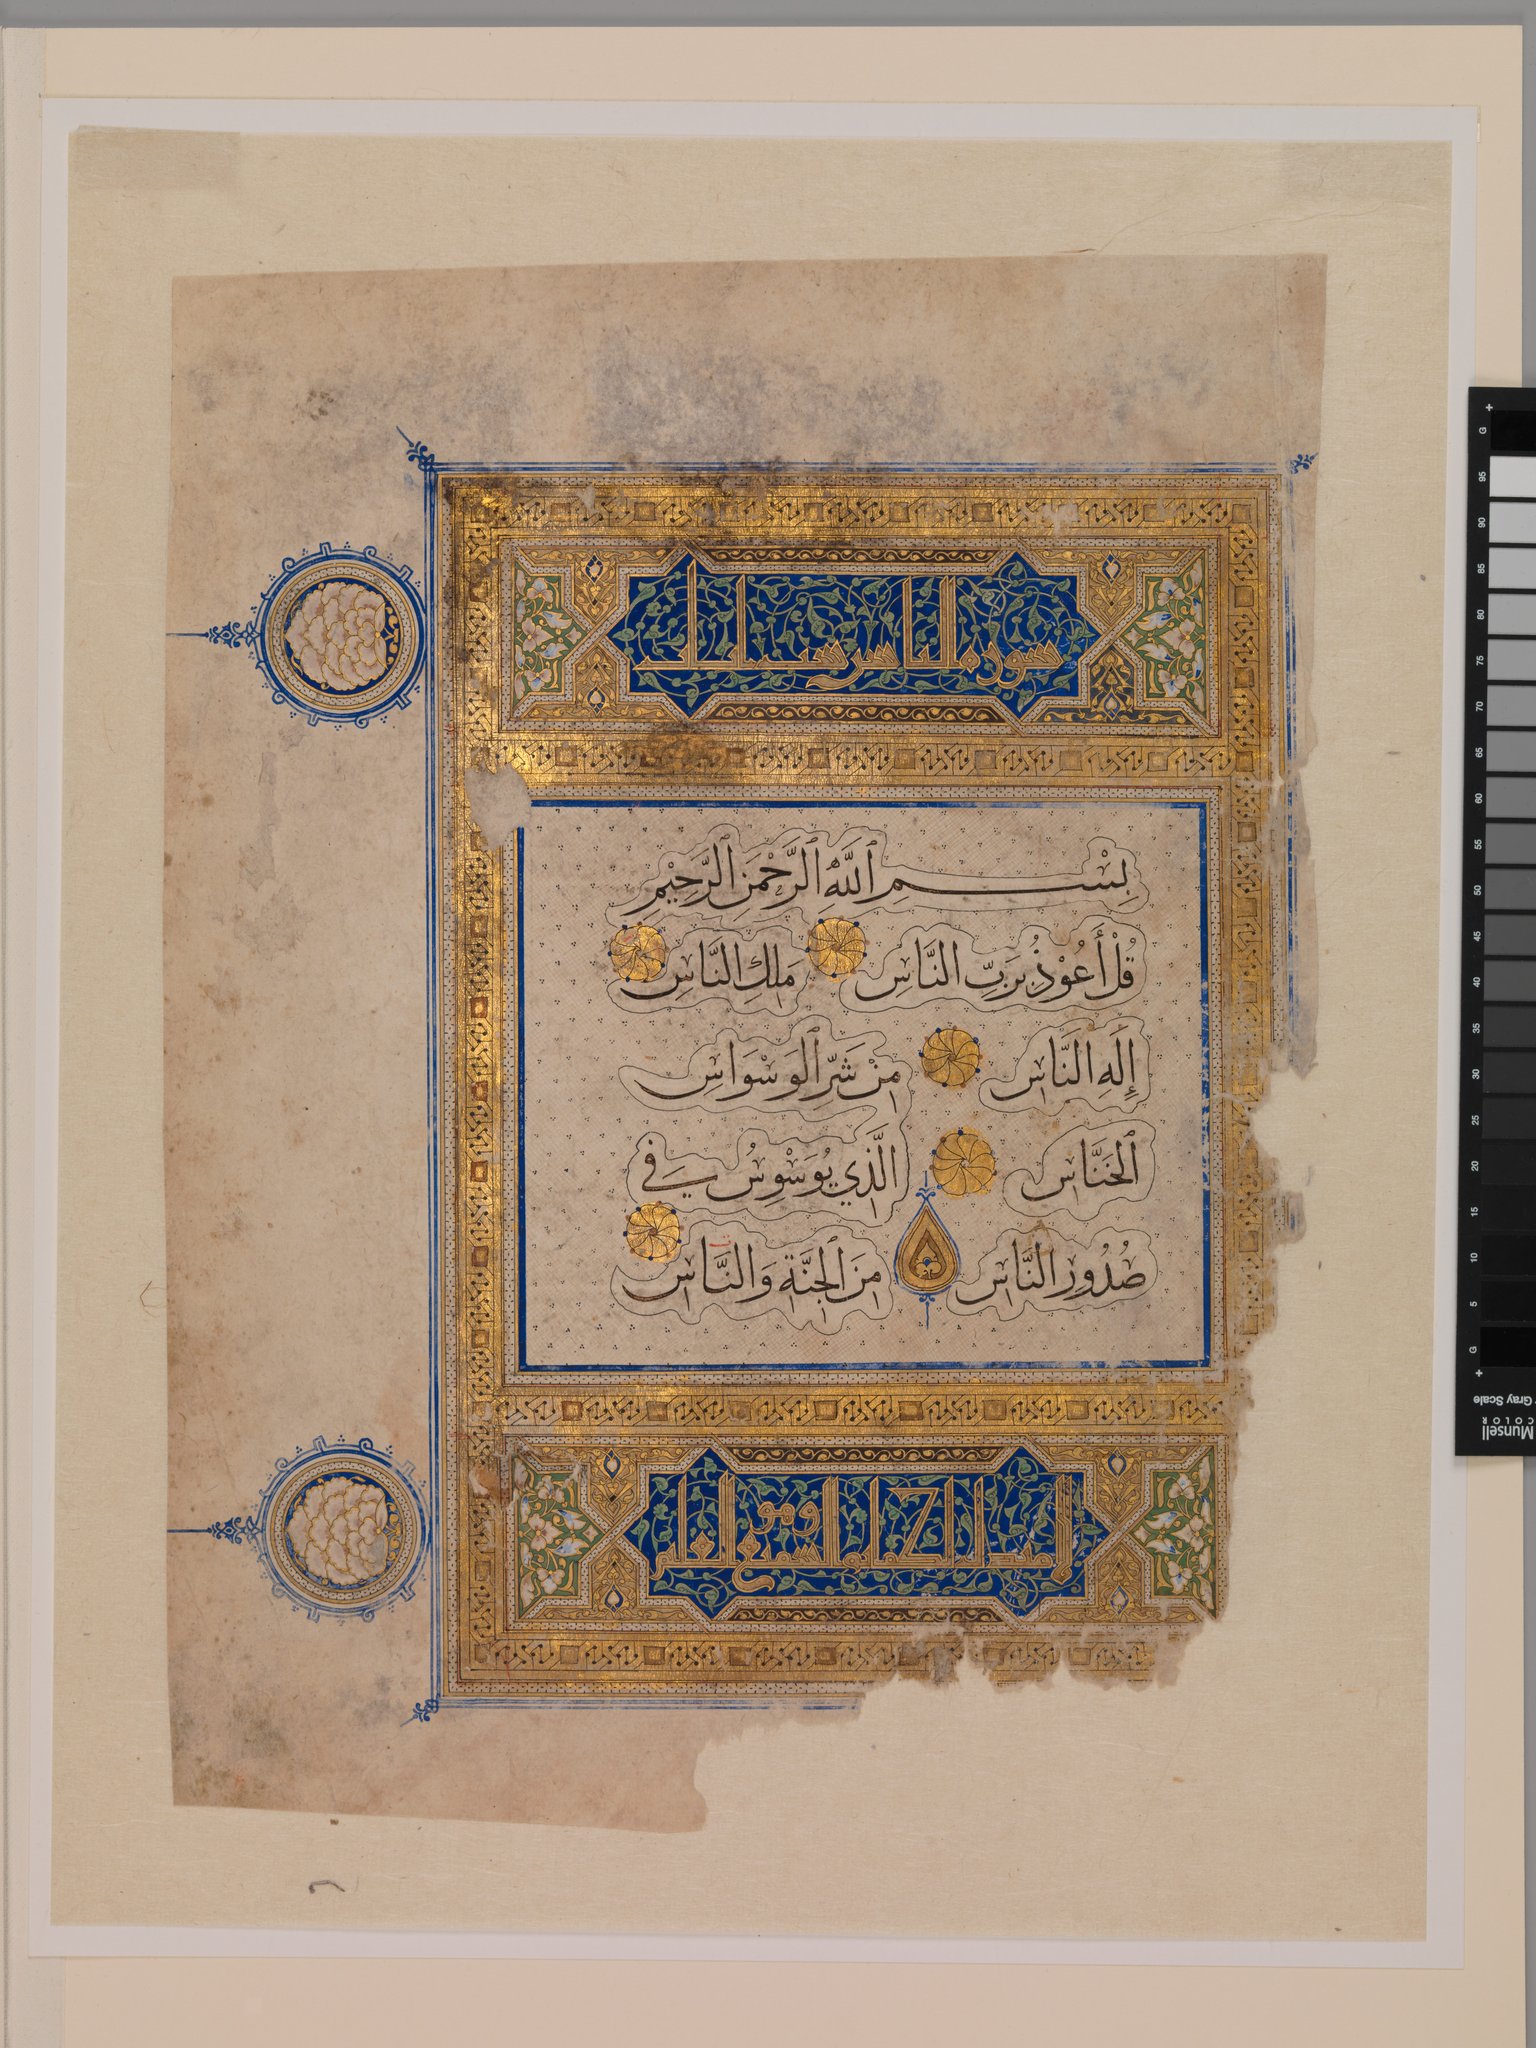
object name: folio from a non illustrated manuscript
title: Folio from a Qur'an Manuscript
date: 1301-1333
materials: gold, ink, paper, watercolor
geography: iran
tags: qur'an,calligraphy